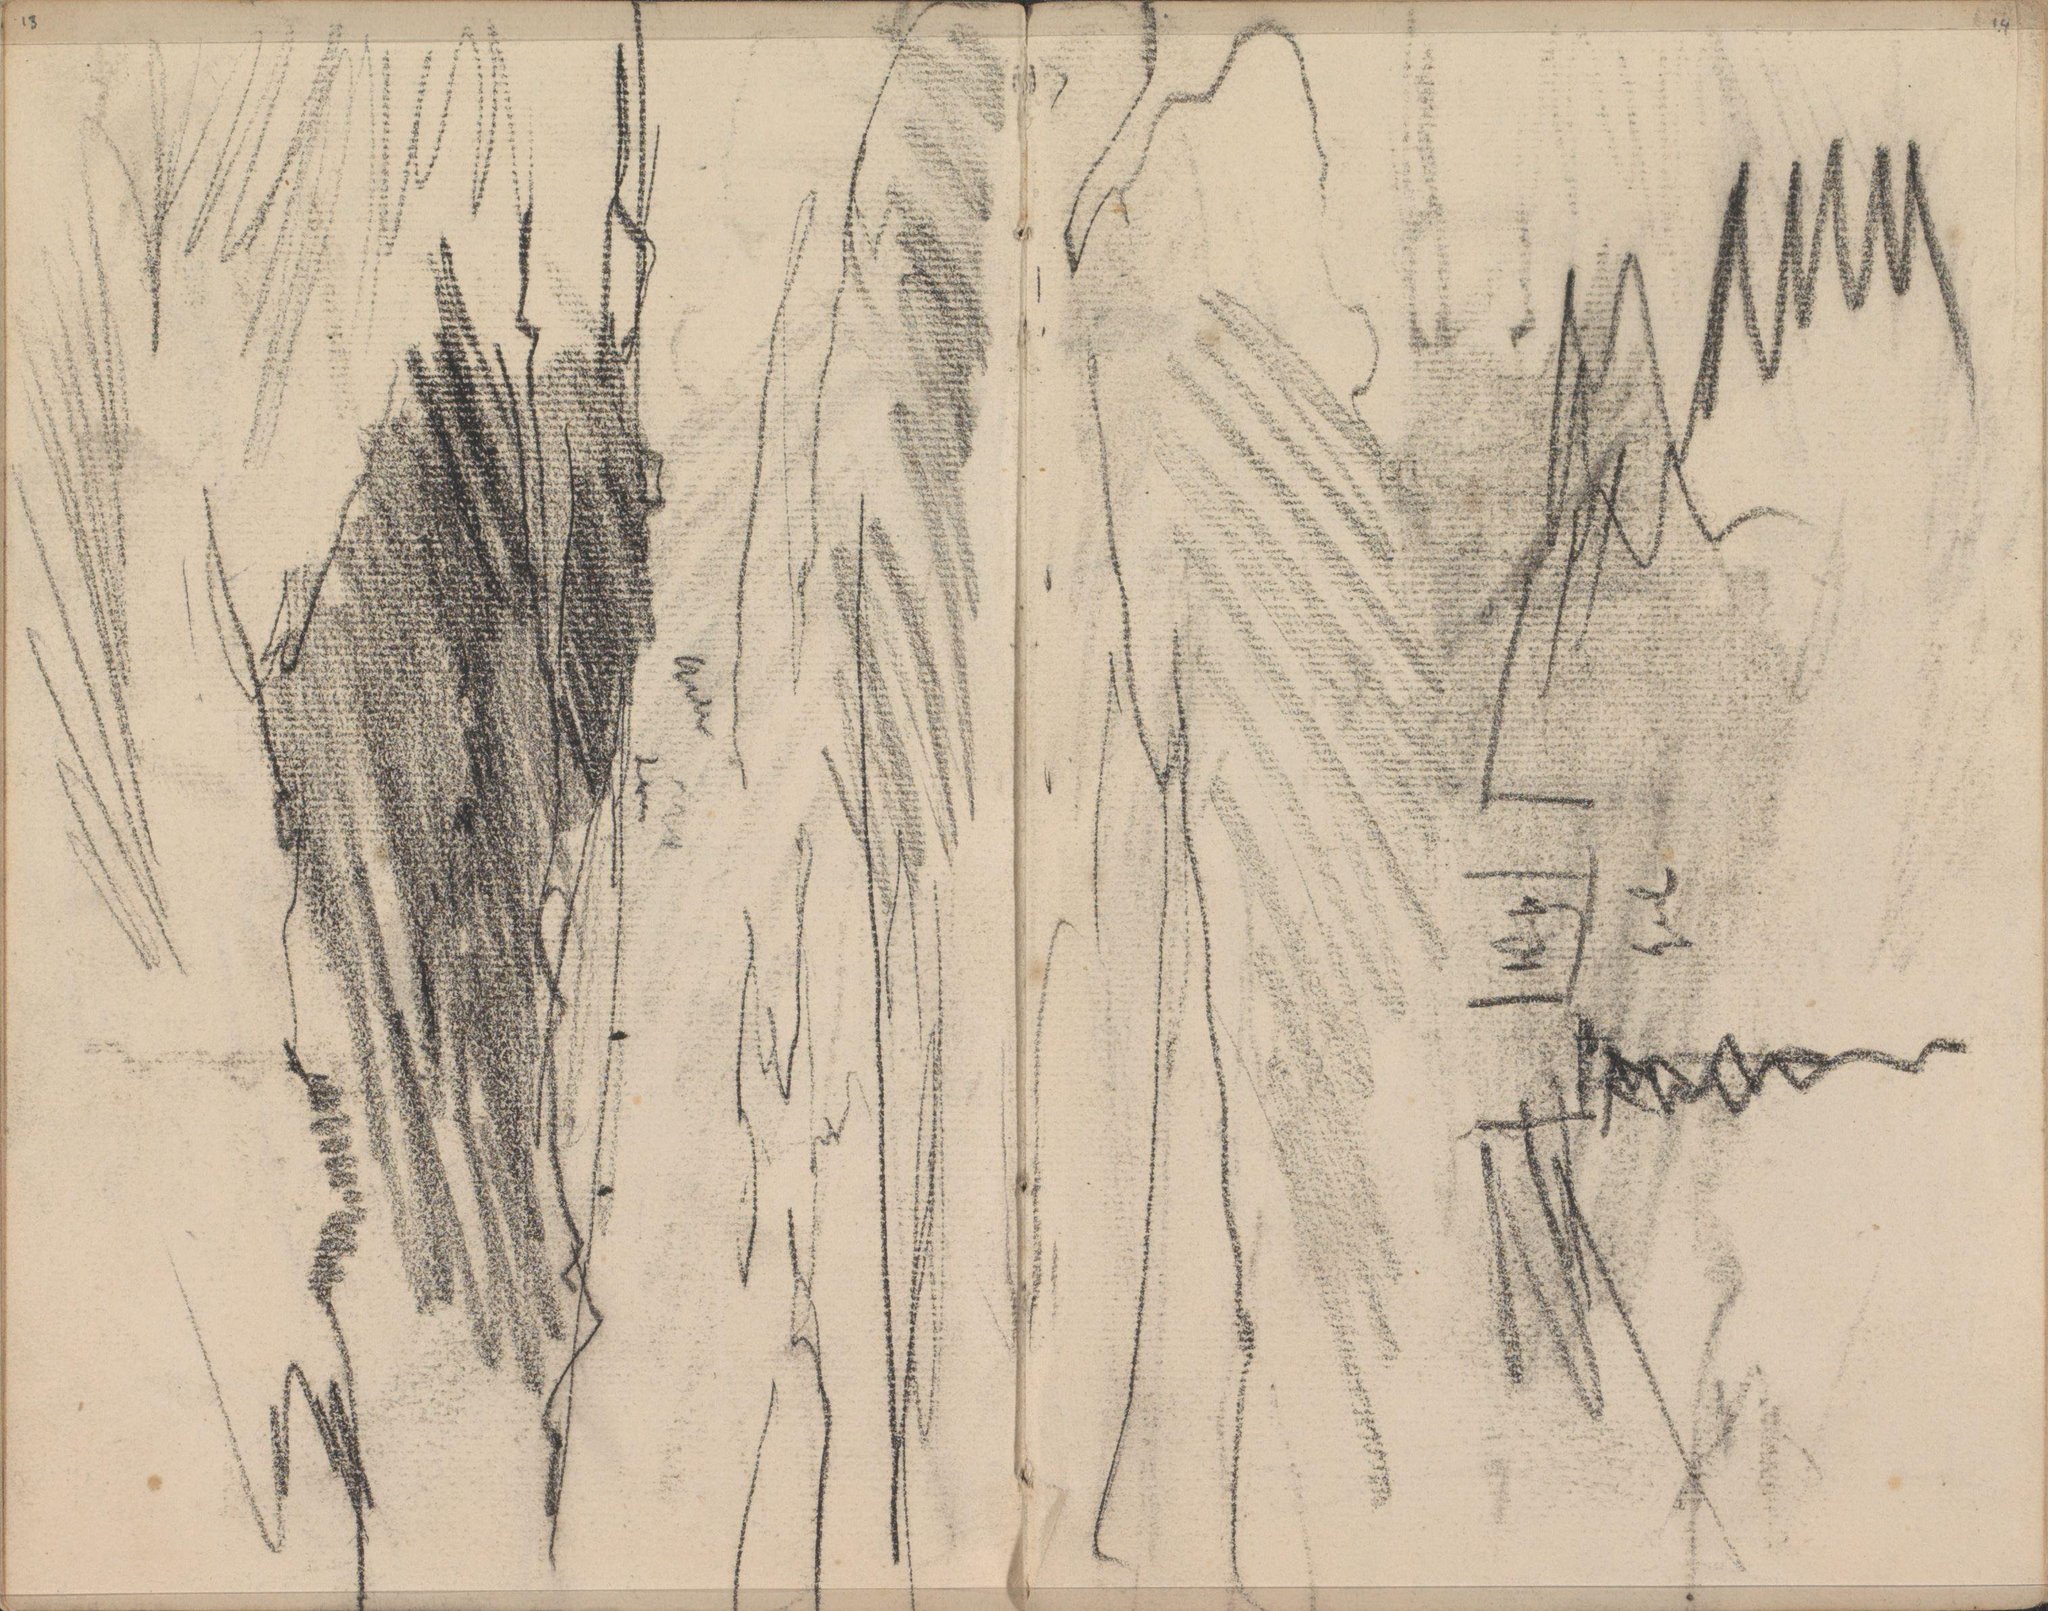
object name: sketchbook leaf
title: Twee landschappen met een wolkenlucht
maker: george hendrik breitner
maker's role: draughtsman, painter, print maker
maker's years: 1857-1923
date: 1886-1923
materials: chalk, paper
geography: amsterdam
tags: landscapes, clouds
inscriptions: kleurnotitie, handgeschreven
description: Pagina 13 en pagina 14 uit een schetsboek met 17 bladen.